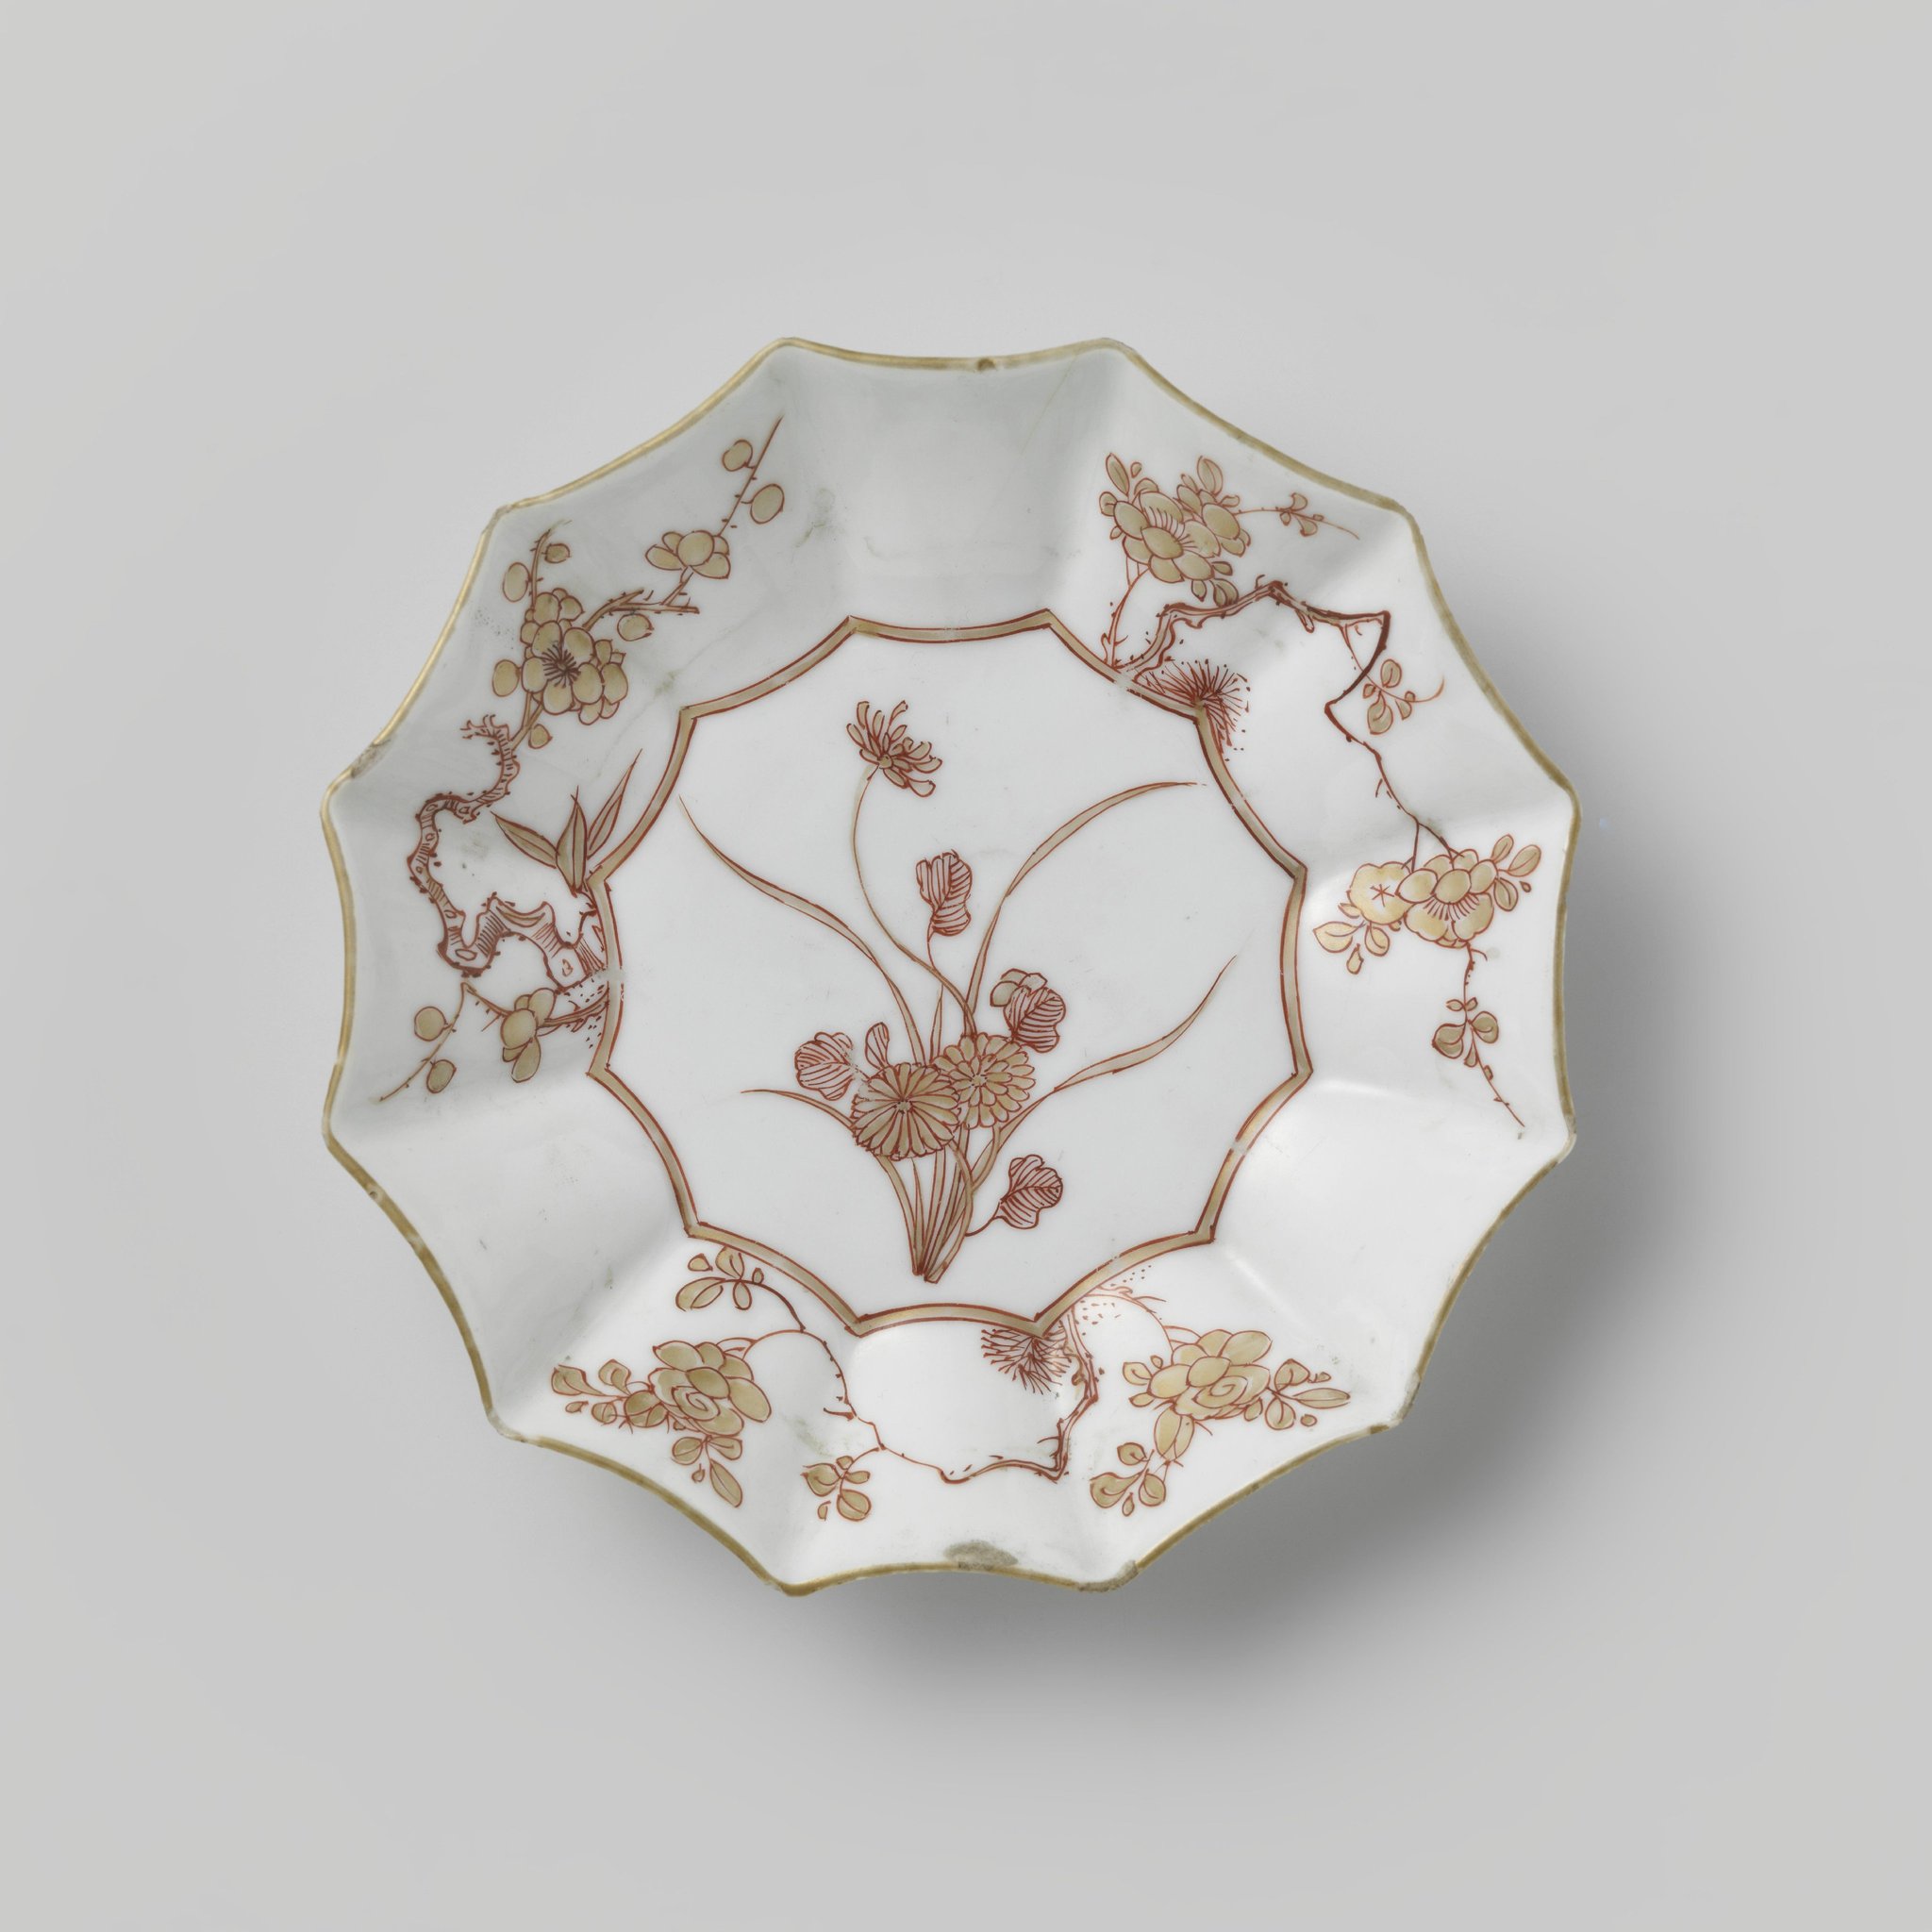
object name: platter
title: Saucer with a flowering plant in a scalloped medallion and four prunus sprays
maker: Anonymous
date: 1680-1720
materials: cobalt, glaze, gold, paint, porcelain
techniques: firing, gilding, turning, vitrification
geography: china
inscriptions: mark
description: Schotel van porselein met geschulpte wand en rand, beschilderd in onderglazuur blauw en op het glazuur rood en goud. Op het plat een bloeiende plant in een geschulpt medaillon; de wand met vier prunustakken. Gemerkt op de onderzijde met een zegelmerk in een dubbele cirkel. Een barst in de rand. Melk en bloed.